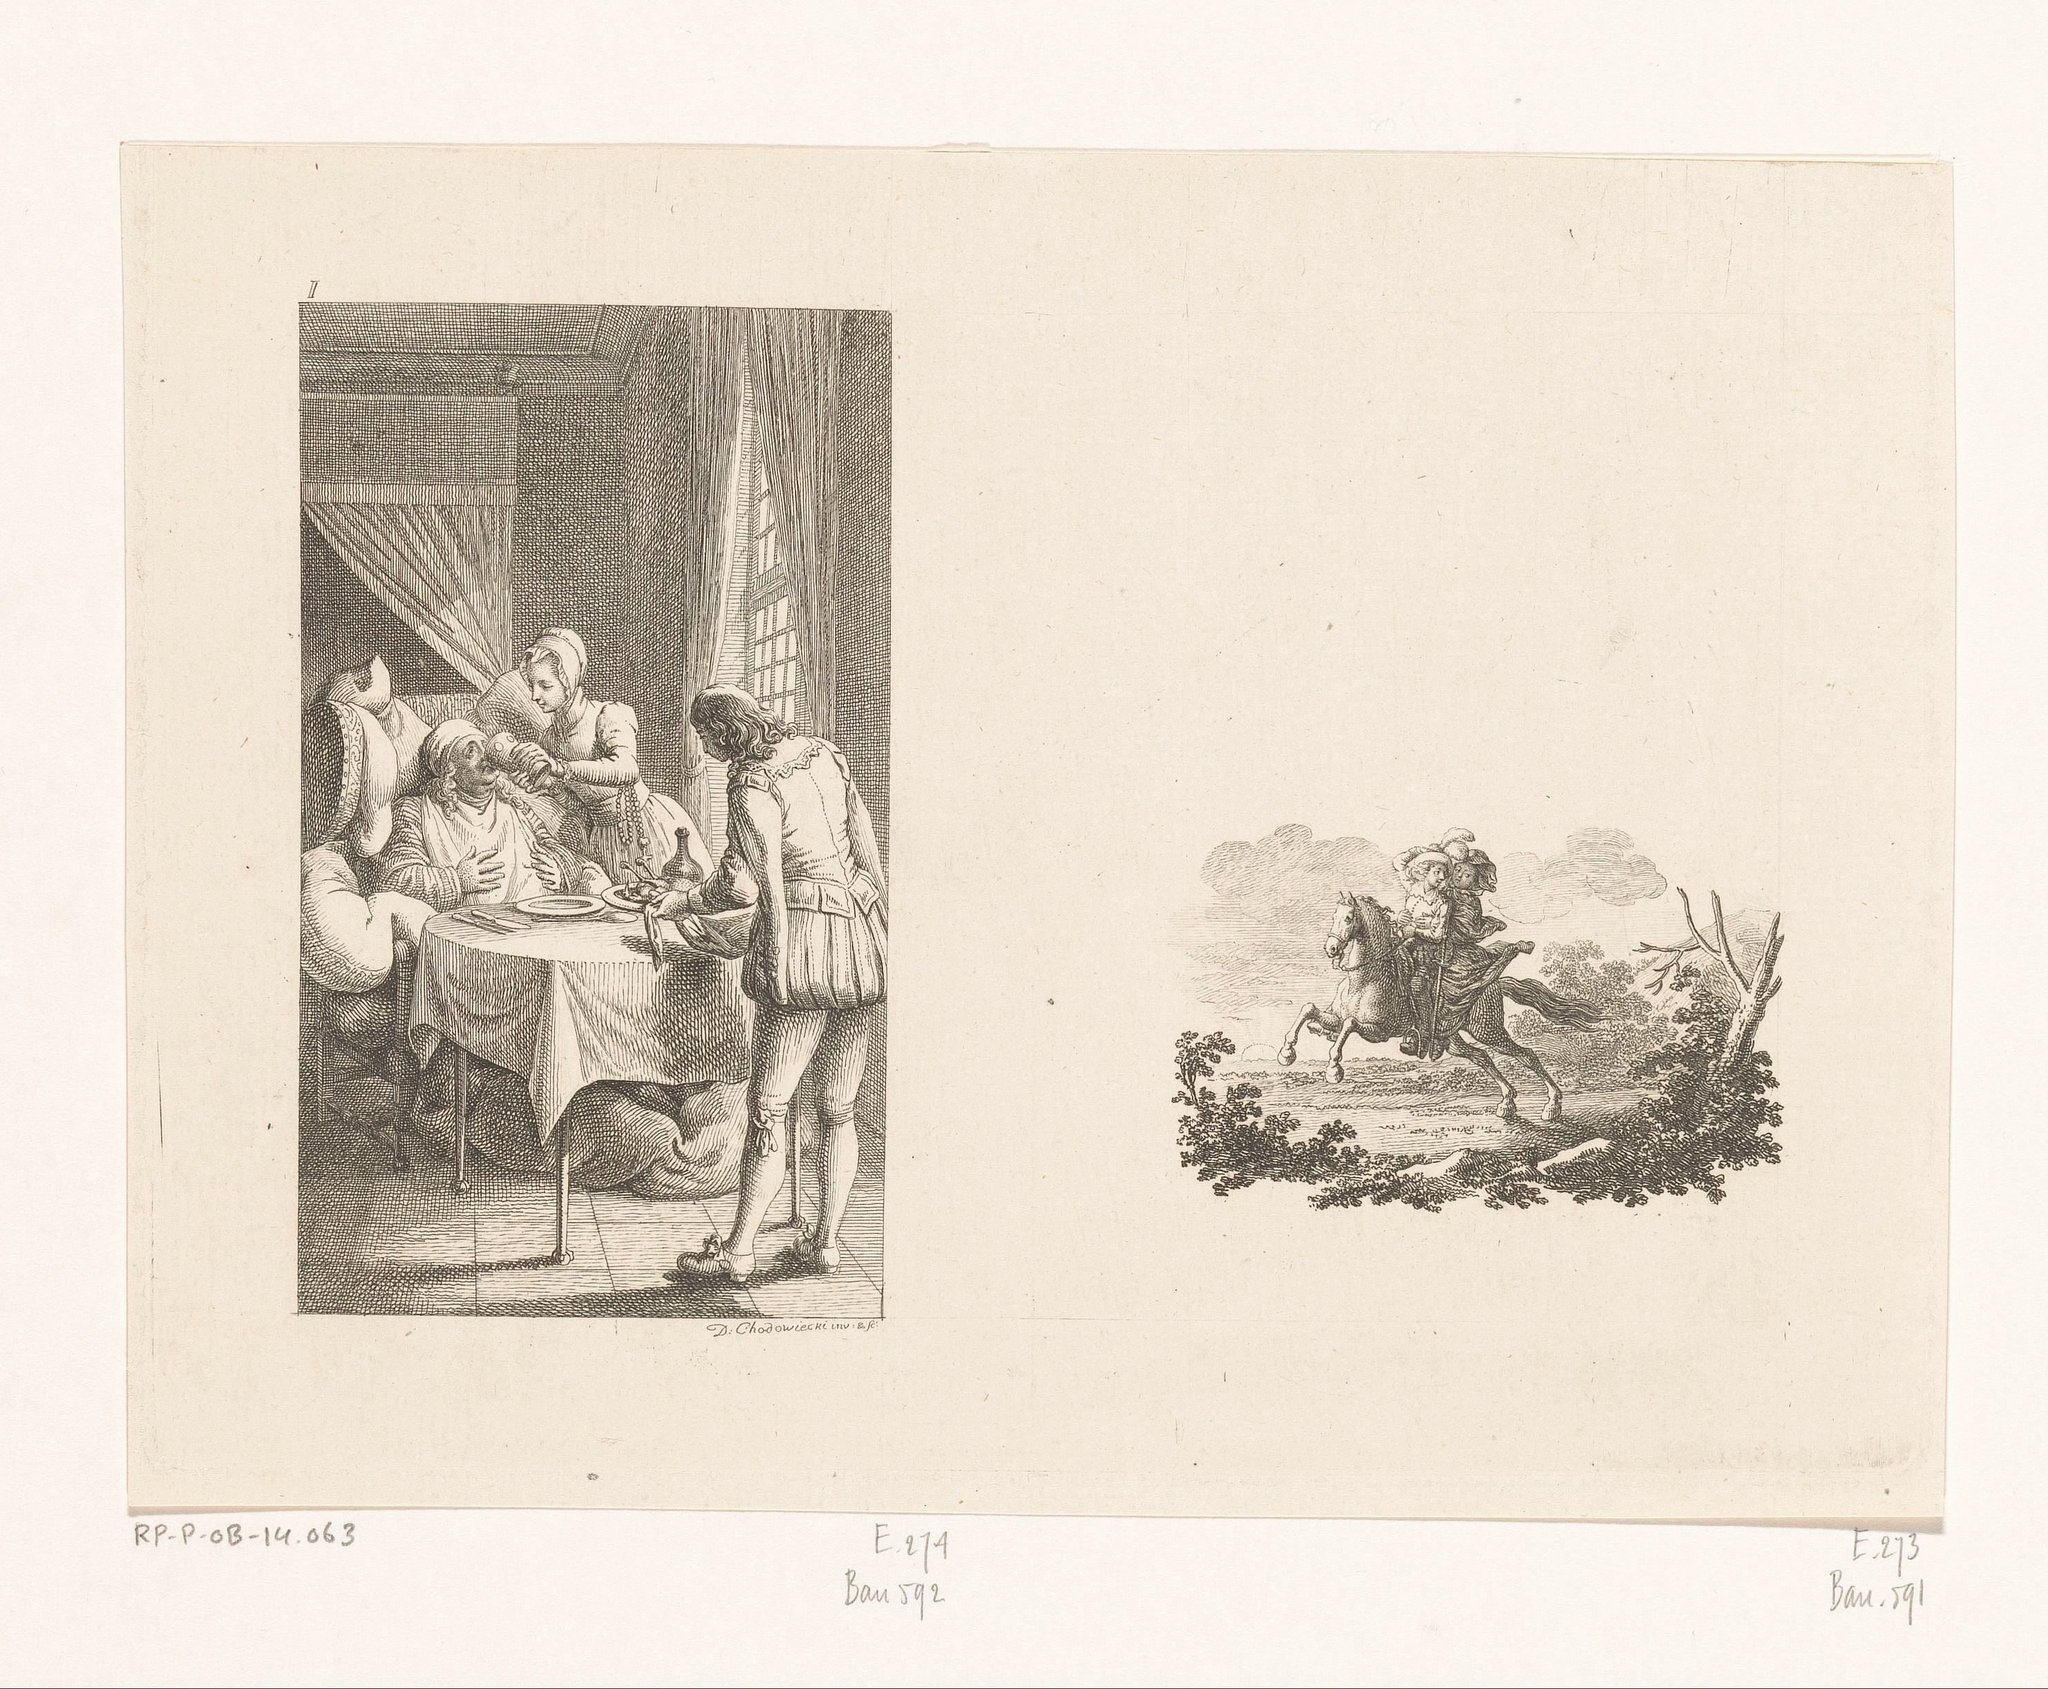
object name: print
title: Gil Blas als bediende en vignet met Gil Blas te paard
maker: daniel nikolaus chodowiecki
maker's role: draughtsman, print maker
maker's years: 1726-1801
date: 1778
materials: paper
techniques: etching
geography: berlin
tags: literature, horse in motion, nursing, tending the sick, house personnel, servants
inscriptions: collector's mark: Lugt 2228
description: Deze prenten maken deel uit van een serie van twaalf voorstellingen die de geschiedenis van 'Gil Blas' illustreren. Een latere staat van deze prenten is ook gebruikt in Alain-René Lesage. Gil Blas von Santillana. Neu übersetzt [door Wilhelm Christhelf Sigmund Mylius]. 6 dln. Berlijn: Christian Friedrich Himburg, 1779, dl. 1.